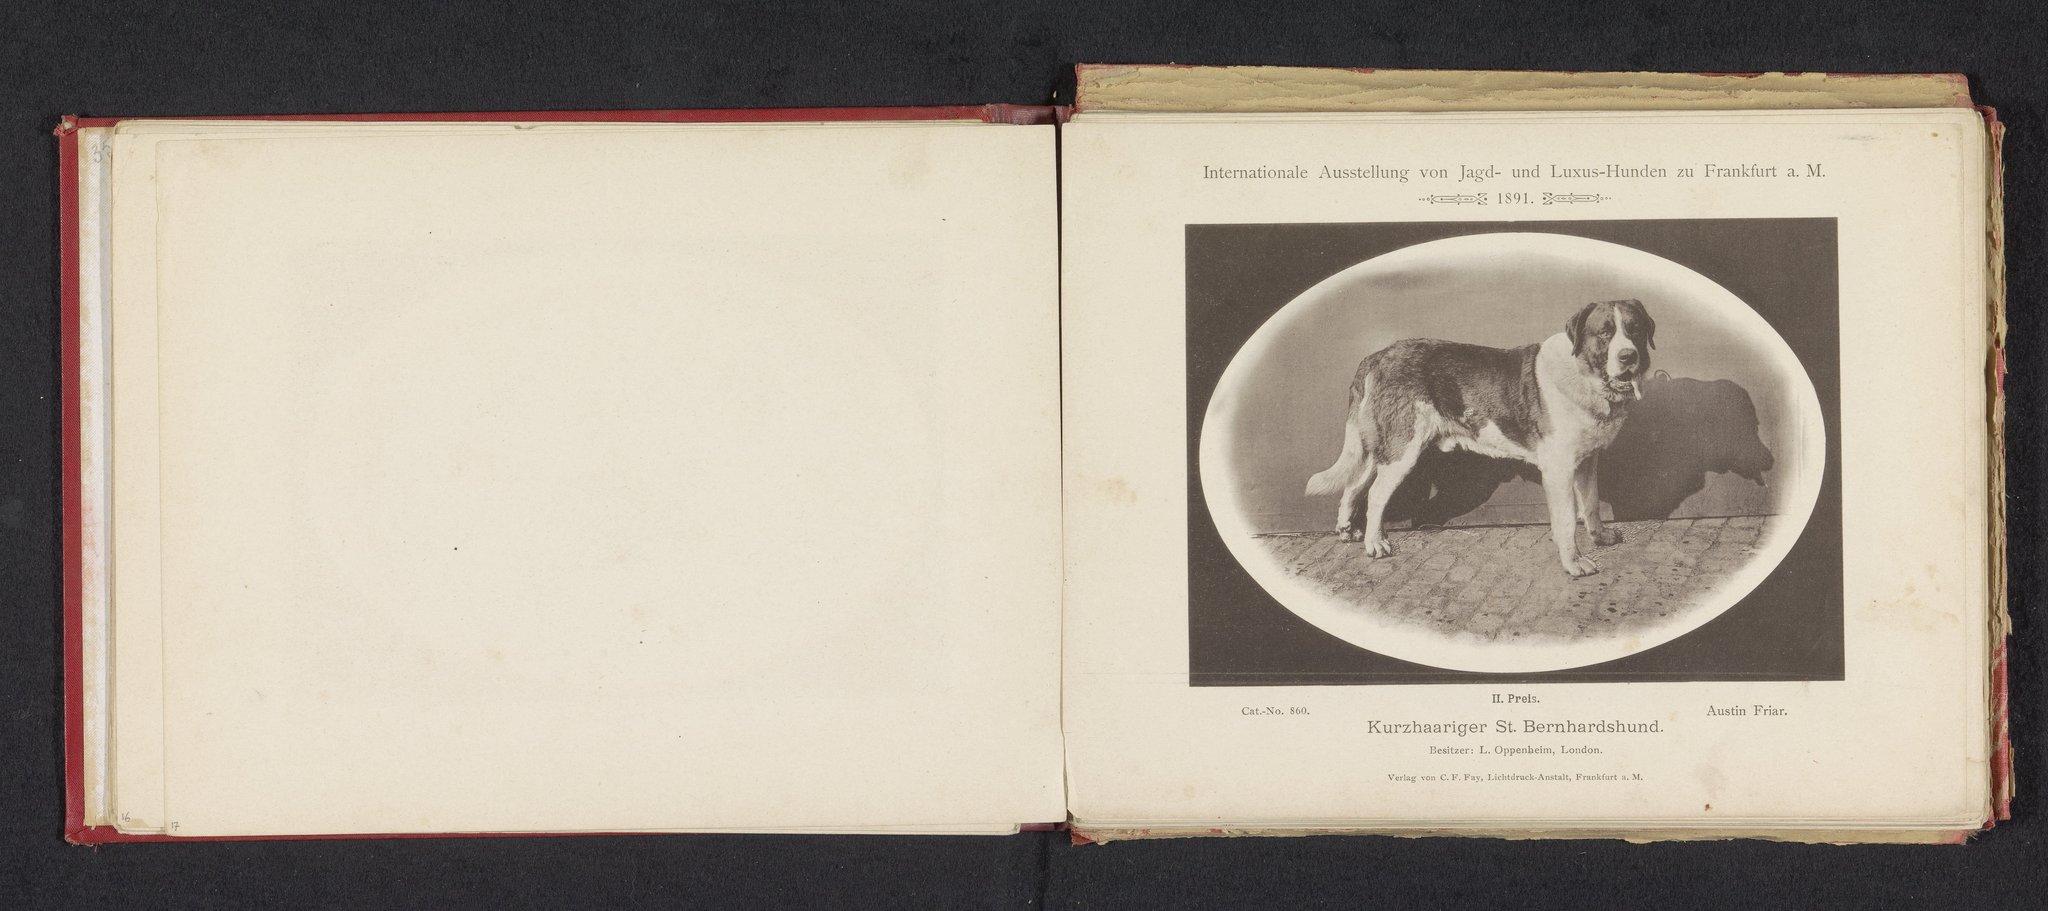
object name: page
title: Sint-bernard Austin Friar die een tweede prijs heeft gewonnen op de Internationale Ausstellung von Jagd und Luxus Hunden in 1891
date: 1891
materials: paper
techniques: photograph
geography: frankfurt am main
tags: dog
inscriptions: number: ‘Cat.-No. 860.’, inscription: ‘II. Preis. Austin Friar. Besitzer : L. Oppenheim, London.’